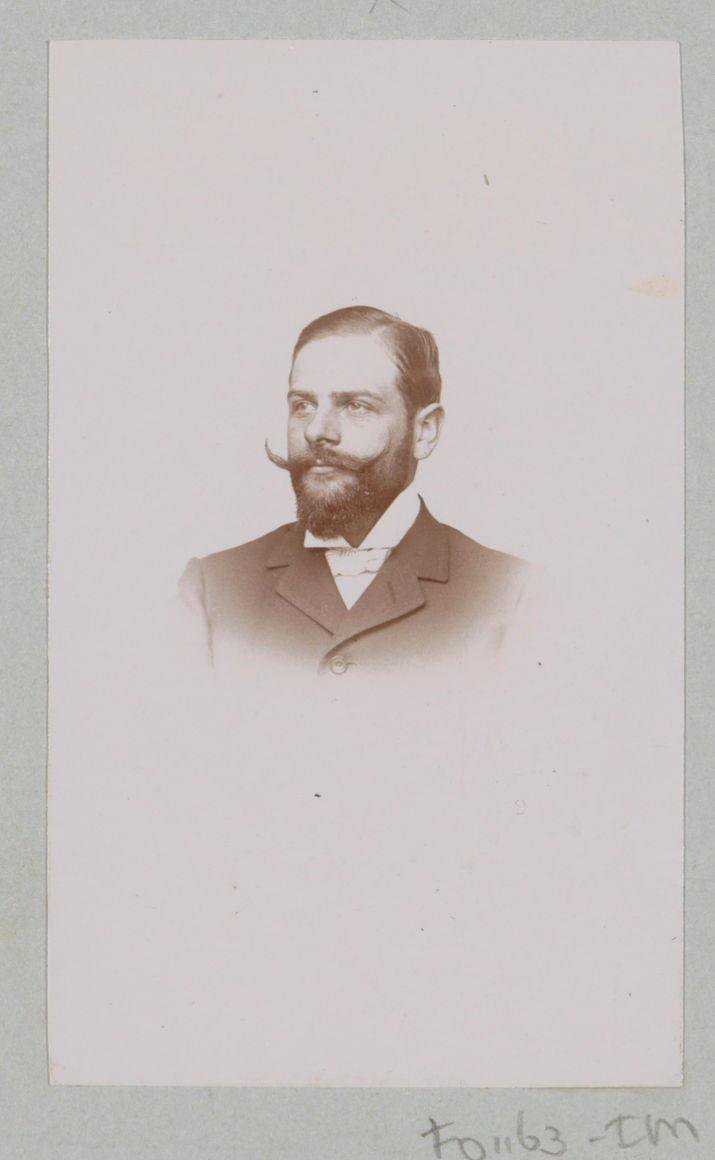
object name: photograph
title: Portret van een man met een baard en een puntige snor, vermoedelijk een Fransman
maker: delizy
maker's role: manufacturer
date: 1899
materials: paper, photographic support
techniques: gelatin silver print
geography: france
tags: moustache, adult man, beard, france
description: Onderdeel van Fotoalbum van een Franse amateurfotograaf met opnames van uitstapjes in Frankrijk, Spanje, België, Luxemburg en Nederland, de eerste automobielen en autoraces.